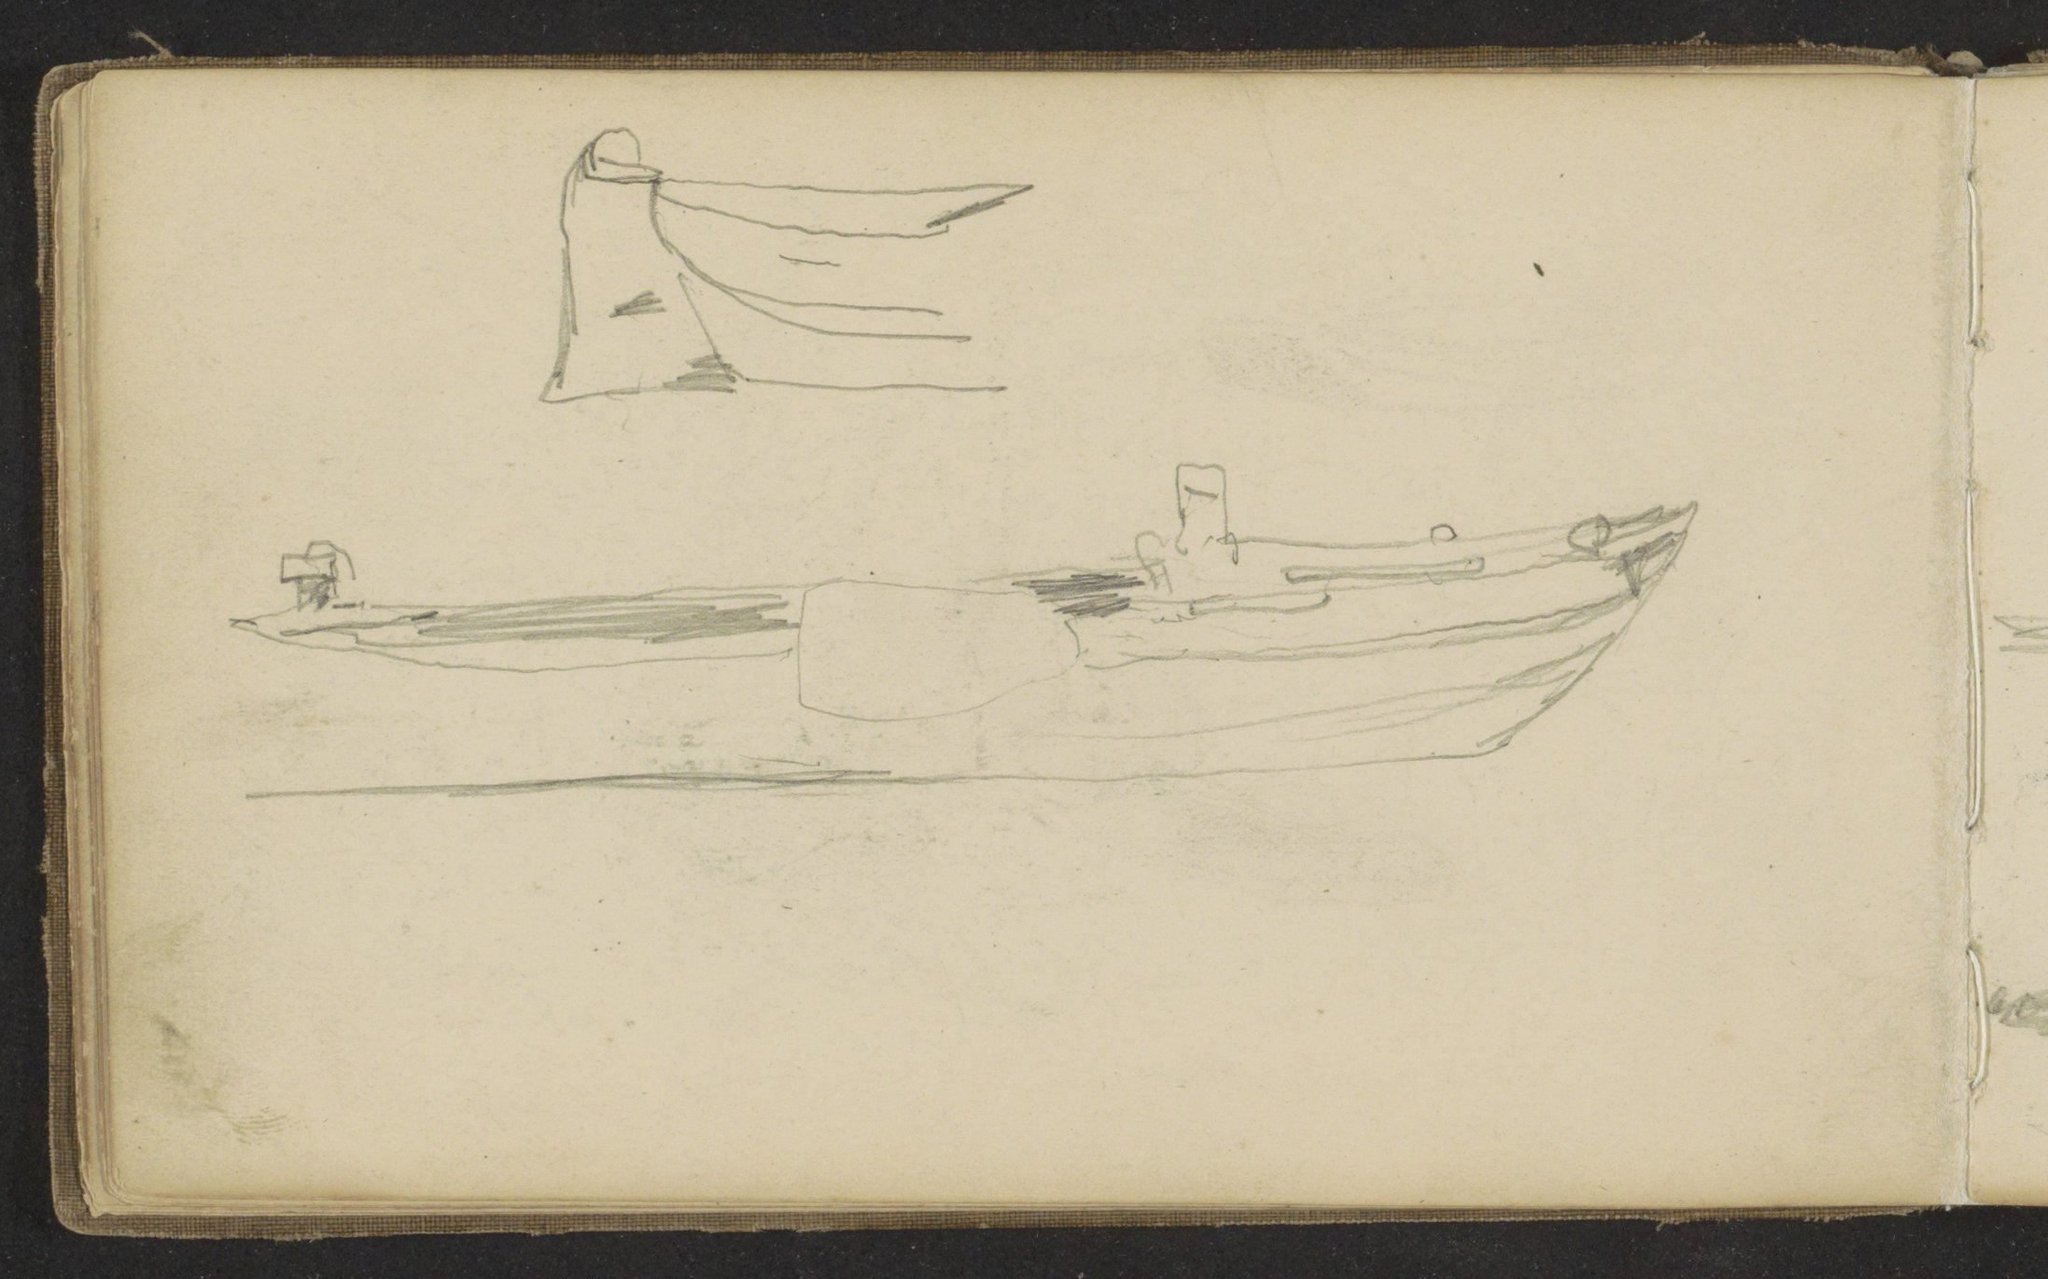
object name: sketchbook leaf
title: Sloep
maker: johan hendrik weissenbruch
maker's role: draughtsman, painter, print maker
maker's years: 1824-1903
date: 1834-1903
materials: paper, pencil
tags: boat propelled by man or animal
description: Blad 7 verso uit een schetsboek met 43 bladen.